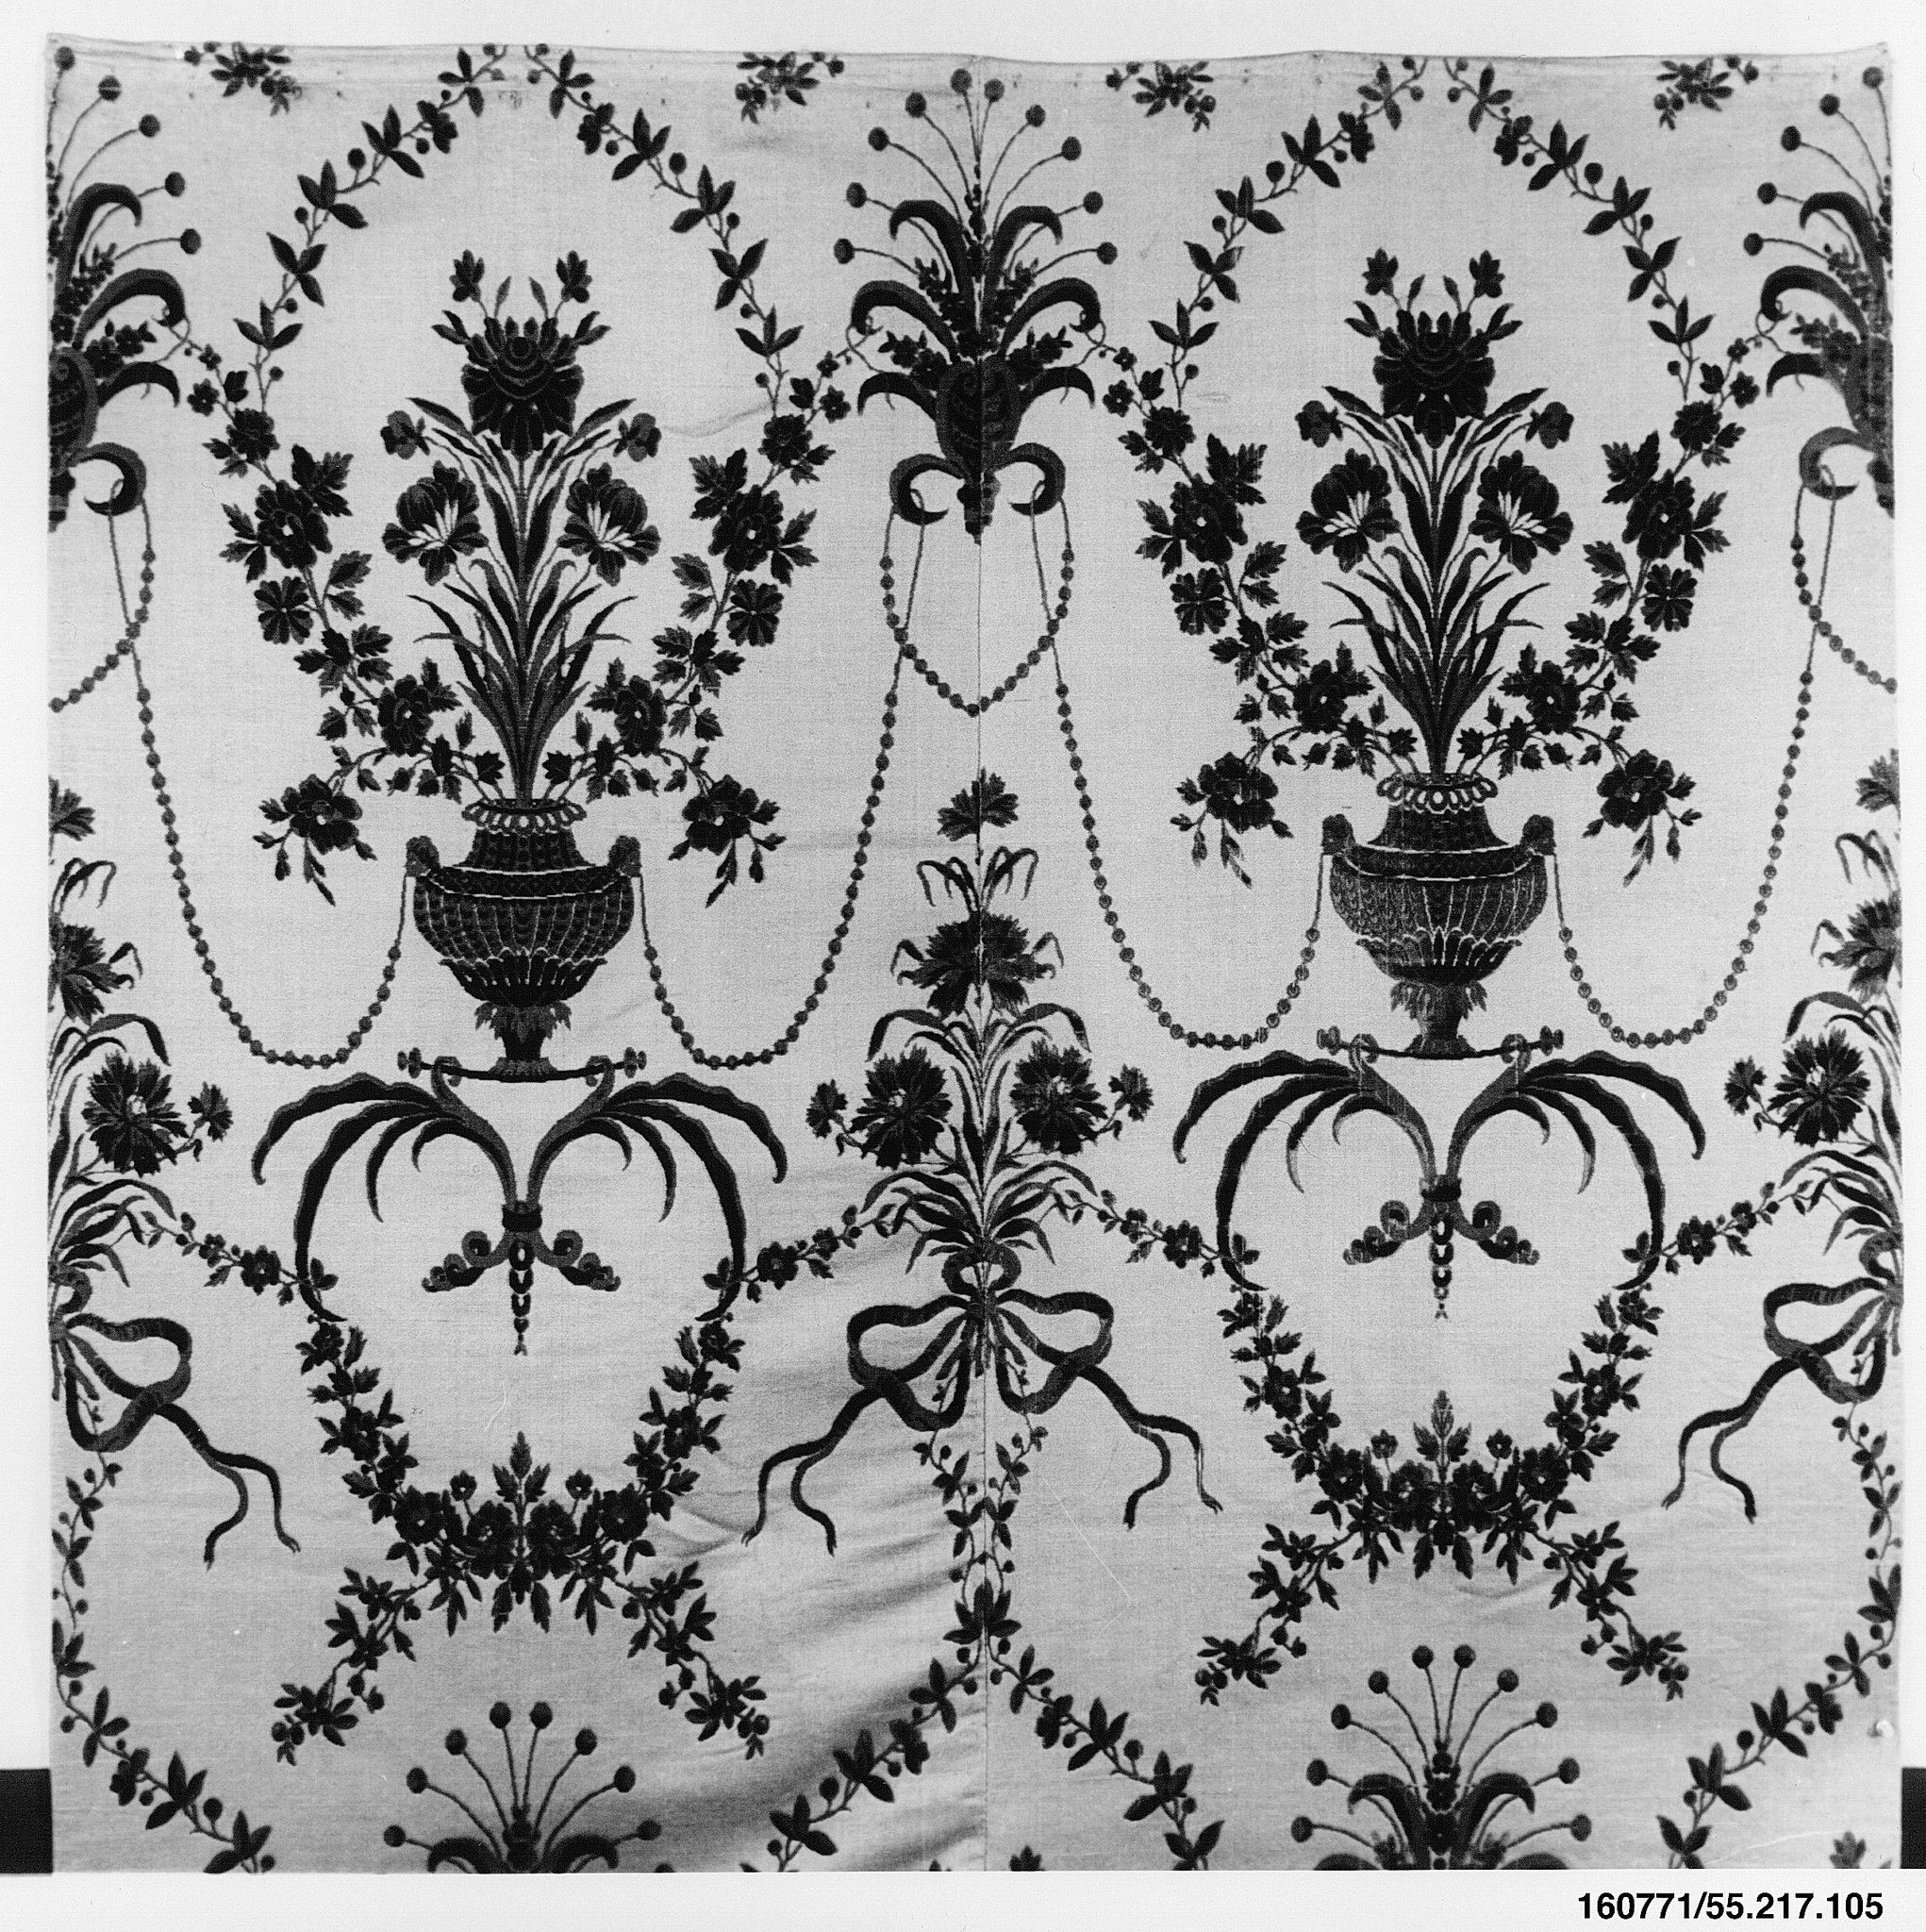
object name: piece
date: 1751-1800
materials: metal thread, silk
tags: flowers